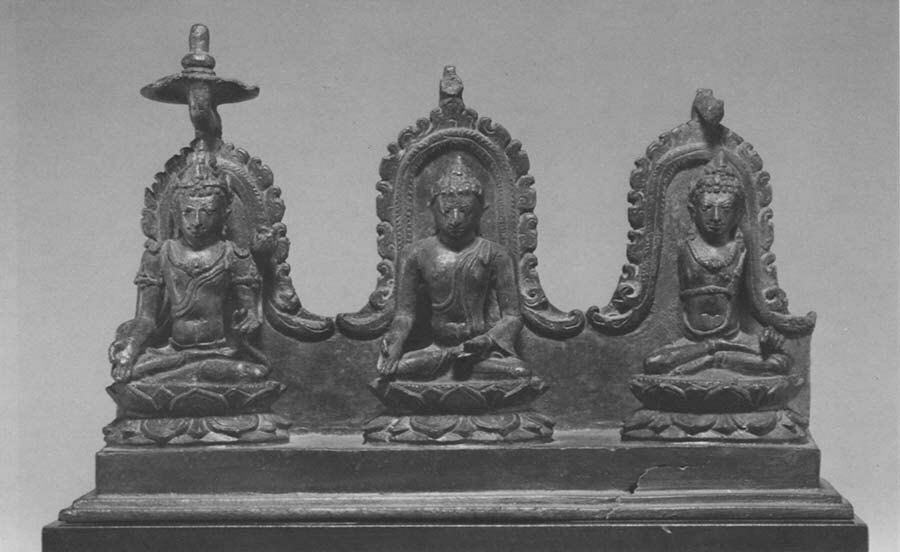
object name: group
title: The Transcendent Buddha Ratnasambhava Flanked by Two Bodhisattvas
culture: indonesian, javanese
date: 867-933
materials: bronze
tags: buddhism,bodhisattvas,buddha